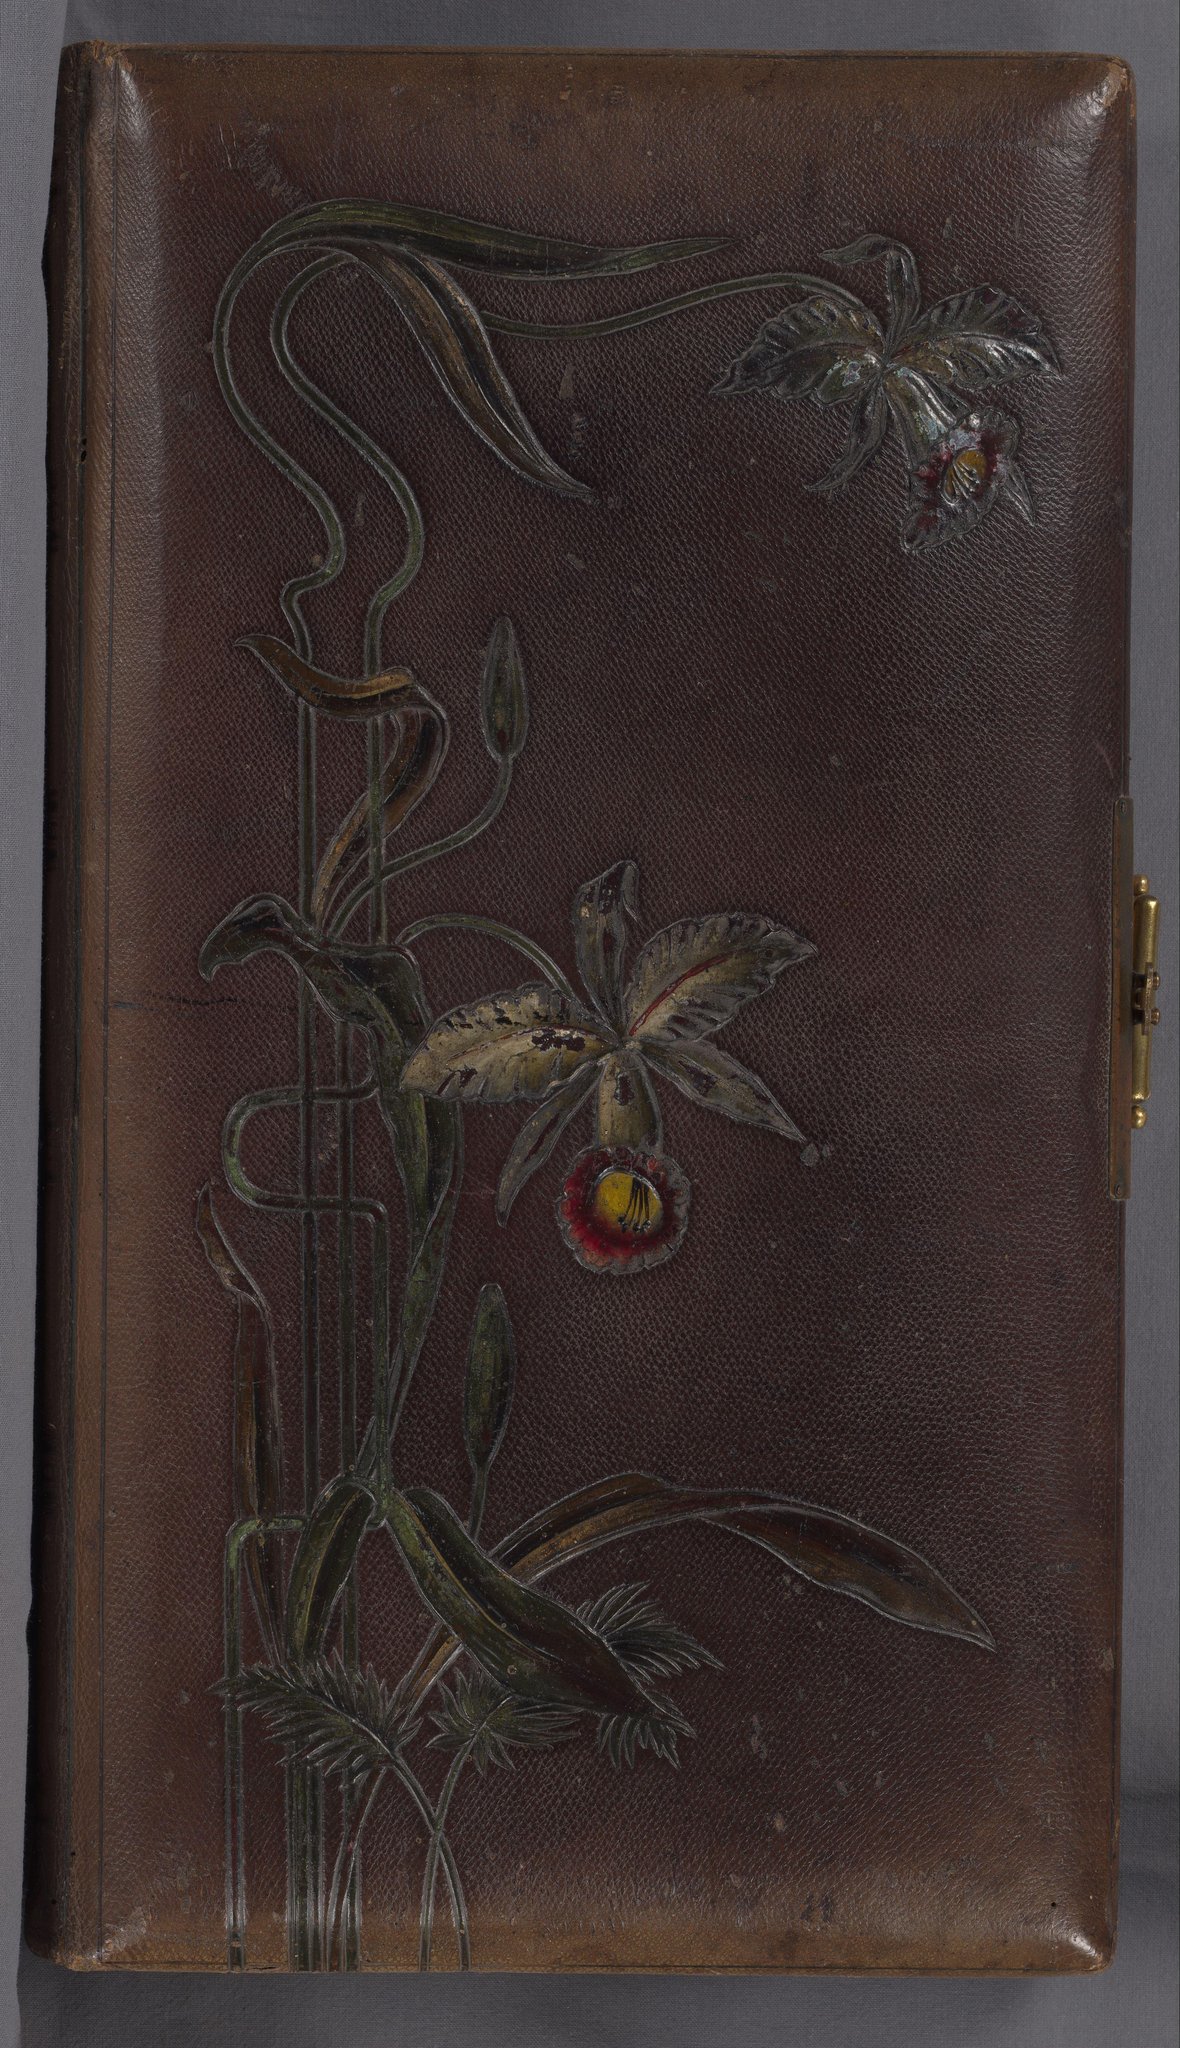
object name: photograph album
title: Familiealbum met honderdtwintig foto's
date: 1860-1920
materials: cardboard, leather, metal, paper, photographic support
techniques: albumen print, decorated paper, gelatin silver print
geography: surabaya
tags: historical persons - bb - woman, child, historical persons, dog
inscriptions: collector's mark: ‘DIENST/ VERSPREIDE/ RIJKSKOLLEKTIES/ (...) A 980’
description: Fotoalbum met 30 pagina's met in totaal 120 foto's in met gouden lijnen omkaderde passe-partouts. Het album bevat 27 kabinetfoto's, 83 cartes-de-visite en 10 foto's van andere formaten. Afgebeeld zijn portretten van onbekende mannen, vrouwen en kinderen en twee foto's van een hond. Slechts twee geportretteerden zijn bij naam bekend, te weten Roger en Raymonde van Hoecke. Volgens de aantekeningen van verzamelaar L.J. Hartkamp betreft het dezelfde familie als in album RP-F-F00687. De foto's zijn gemaakt door verschillende Belgische, Franse, Nederlandse en Nederlands-Indische fotografen, waaronder Herman Salzwedel (16) en Woodbury & Page (4). Van 17 foto's is de fotograaf anoniem.